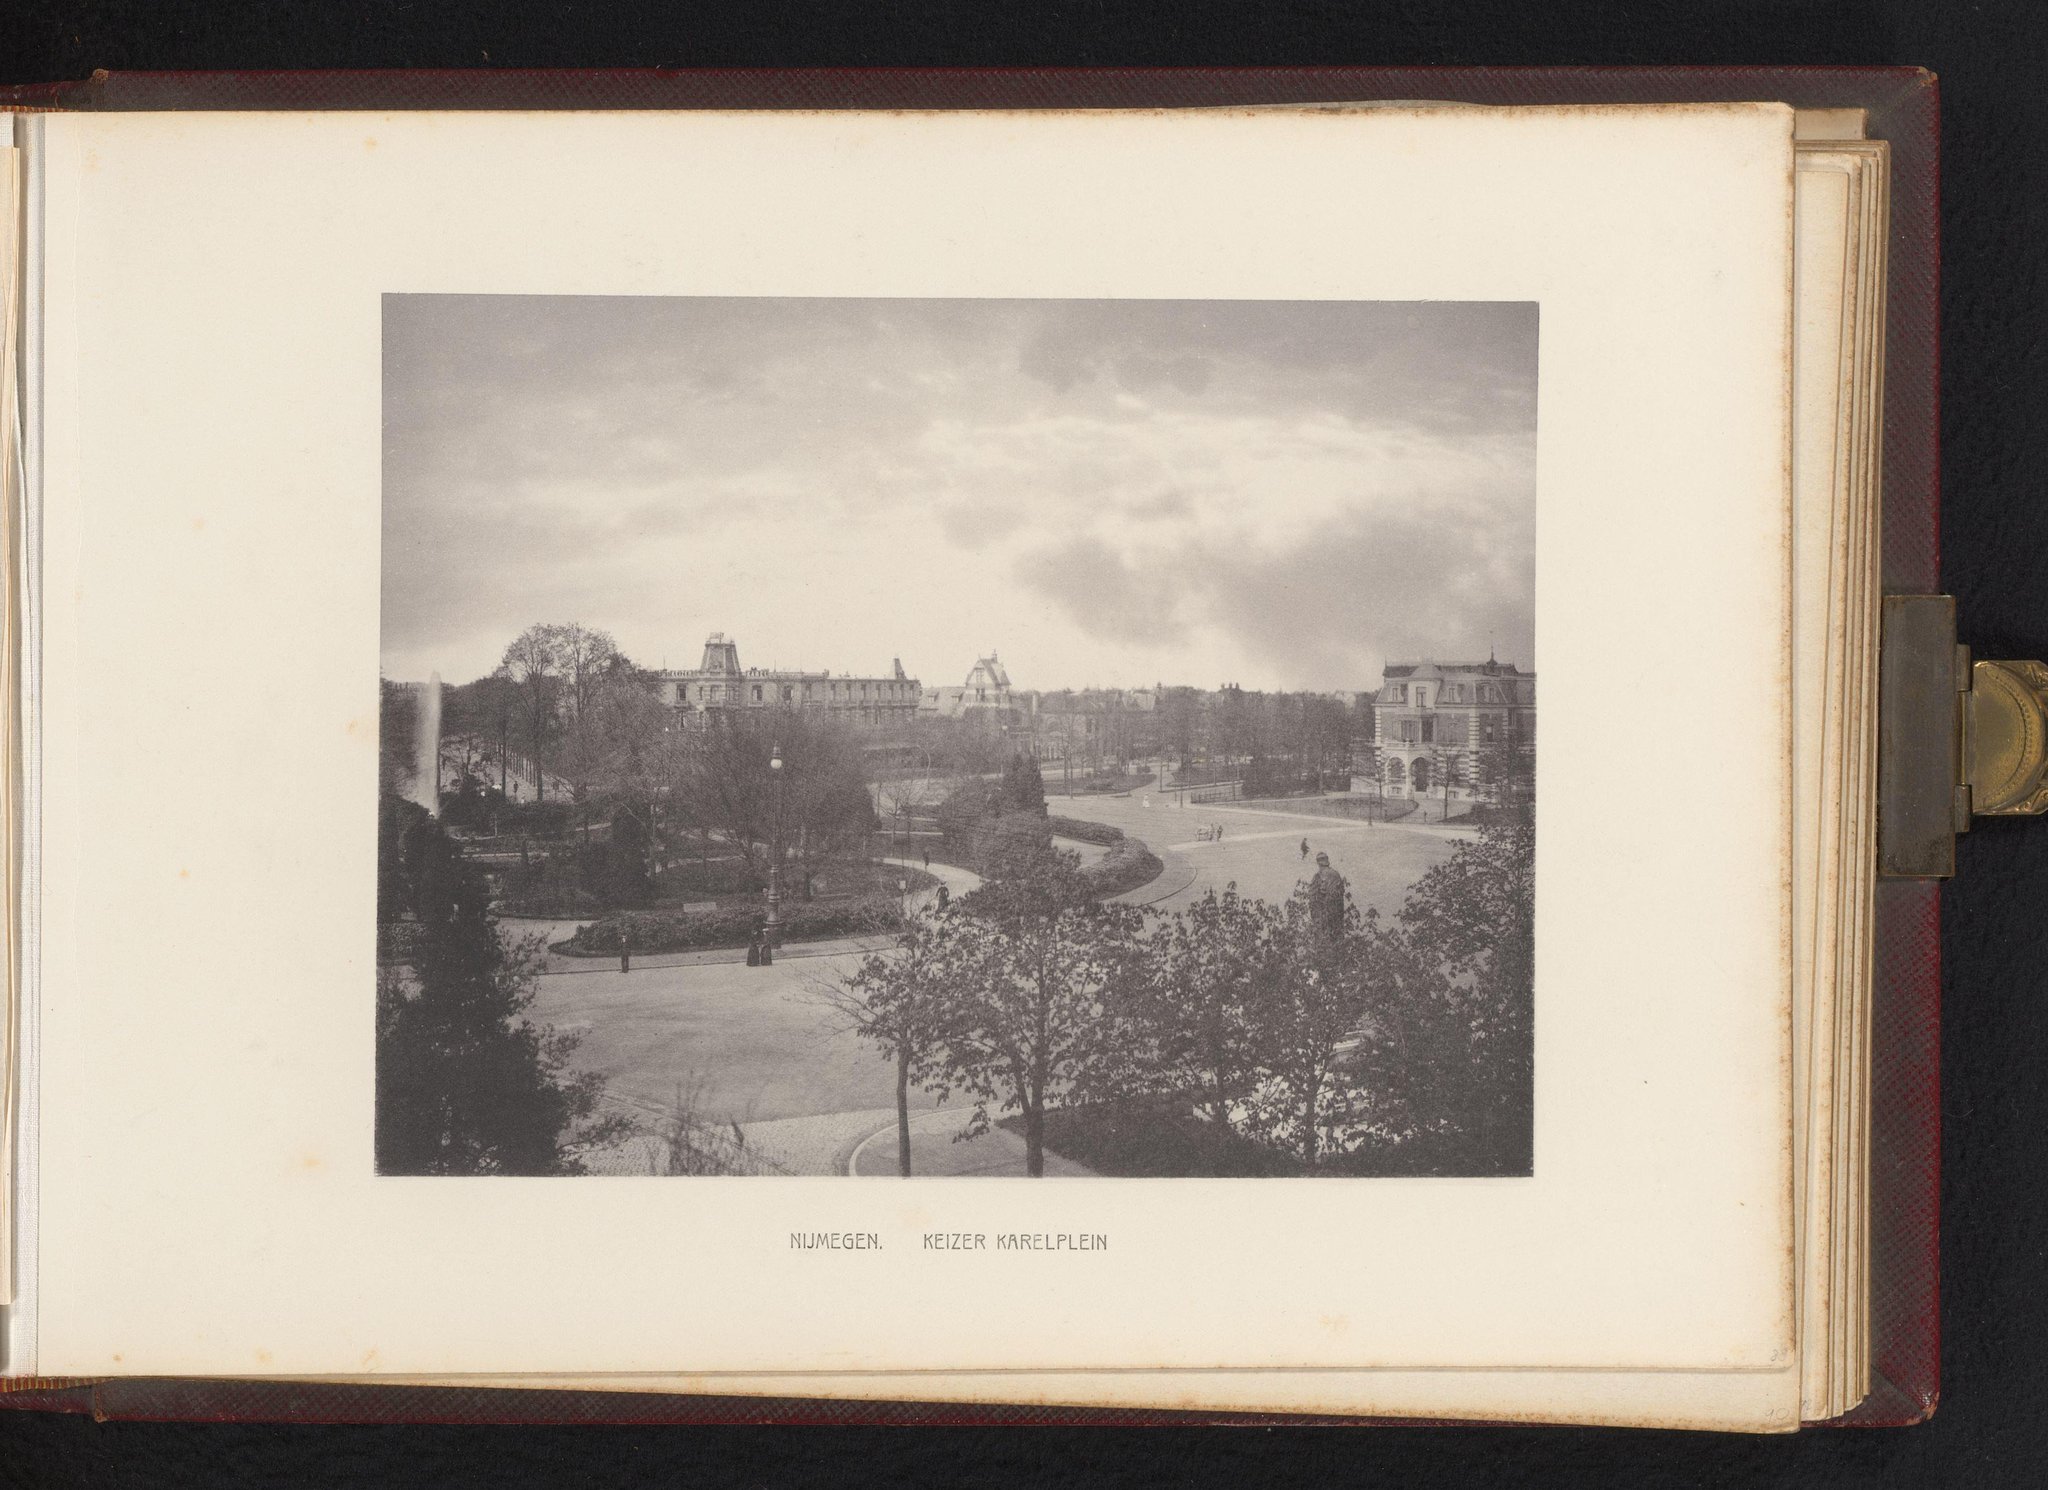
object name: album leaf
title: Gezicht op het Keizer Karelplein te Nijmegen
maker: Anonymous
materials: paper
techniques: photograph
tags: square, place, circus, etc., nijmegen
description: Deze pagina maakt deel uit van een album.